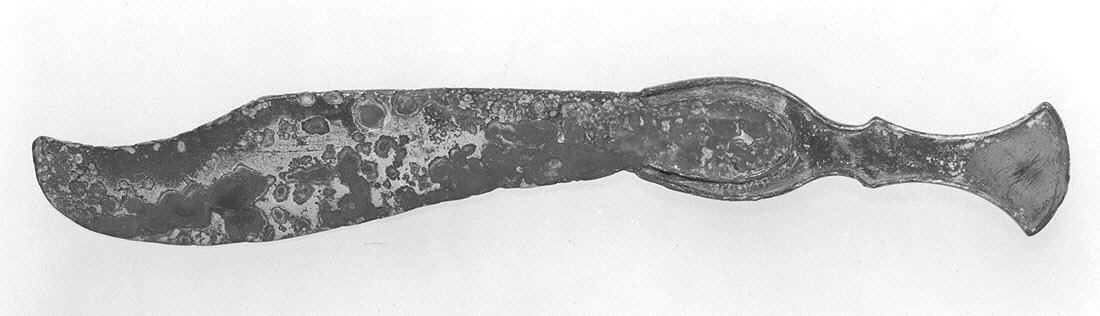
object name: dagger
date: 1000-1 BCE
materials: bronze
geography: transcaucasia